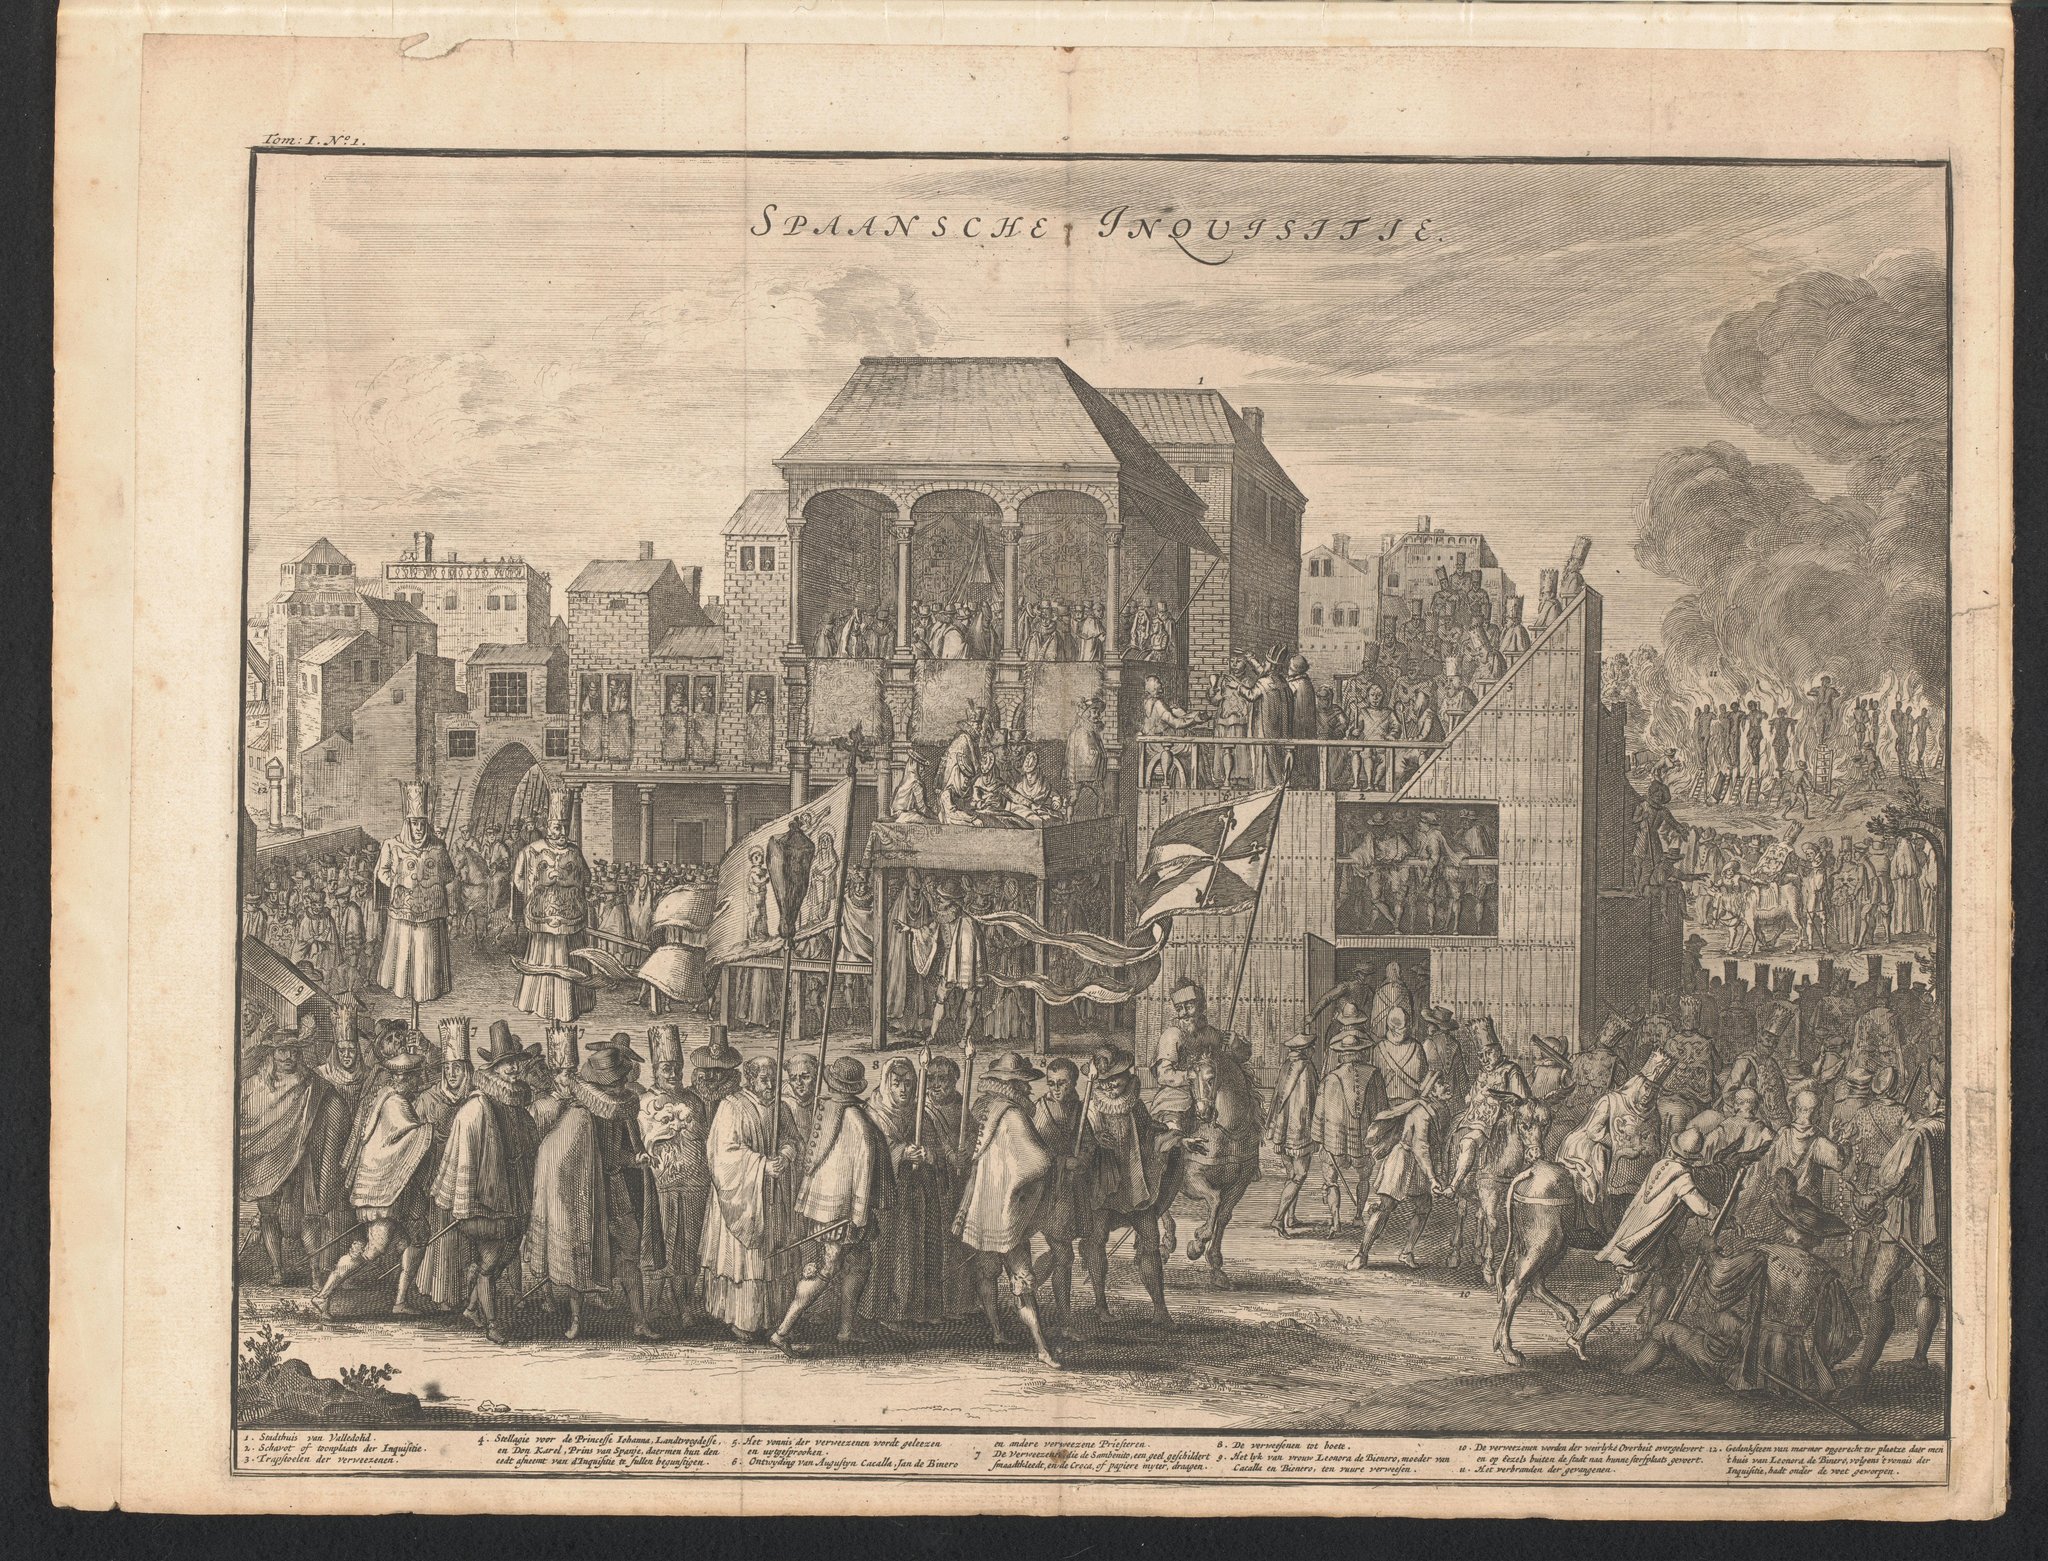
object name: print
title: Spaansche Inquisitie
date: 1730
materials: paper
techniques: etching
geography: northern netherlands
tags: execution of heretic, e.g. by burning at the stake, 'auto-da-fé'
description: Prent waarschijnlijk uit: Le Clerc, Jean. Geschiedenissen der Vereenigde Nederlanden, sedert den aanvang van die Republyk tot op den Vrede van Utrecht in 't jaar 1713 en het Tractaat van Barriere in 't jaar 1715 gesloten. Amsterdam: Zacharias Chatelain, 1730, dl. 1, p. 2-3. Eerdere staat ook gebruikt in: Hooft, Pieter Corneliszoon. Nederlandsche historien; Seedert de Ooverdraght der Heerschappye van Kaizar Karel den Vyfden op Koning Philips zynen Zoon (...). Amsterdam: Henrik Wetstein en Peter Sceperus, 1703, dl. 1, p. 26-27.